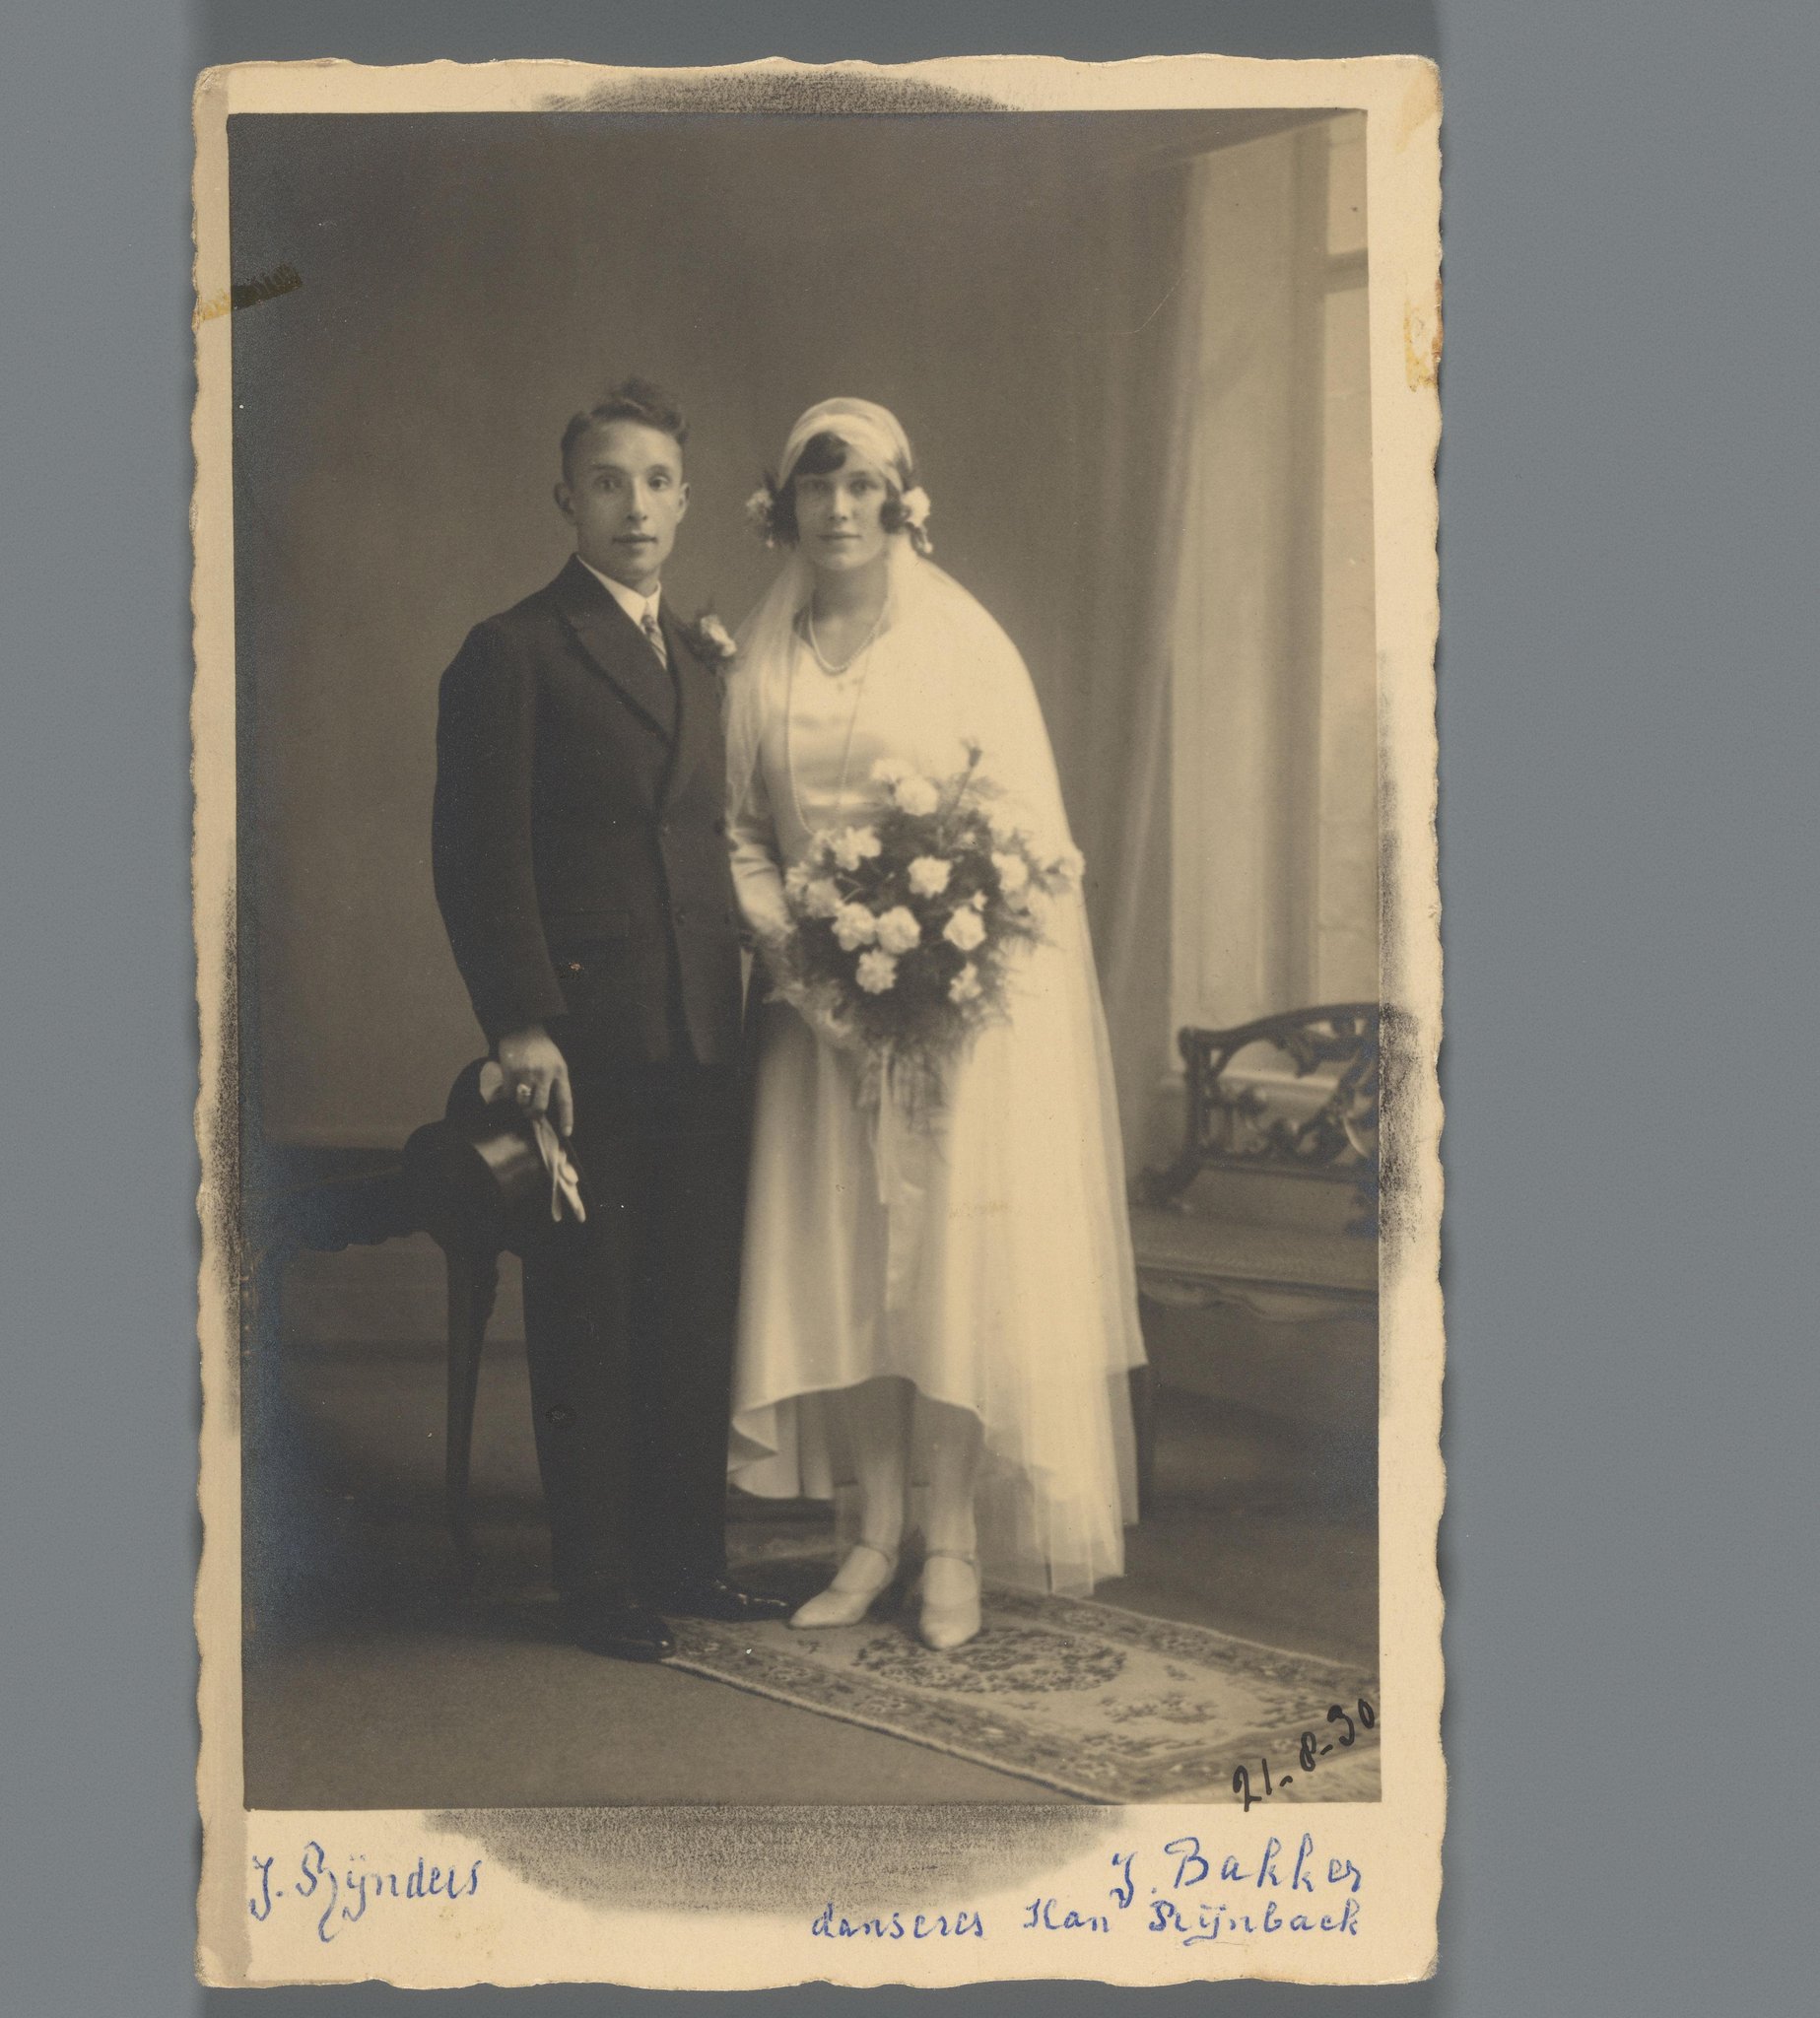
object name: photograph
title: Portret van een bruidspaar, aangeduid als J. Rijnders en J. Bakker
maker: Anonymous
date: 1930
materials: paper, ink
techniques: gelatin silver print, writing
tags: bride and groom in wedding-dress, anonymous historical persons portrayed in a double portrait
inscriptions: inscription: ‘danseres Han Rijnback [?]’